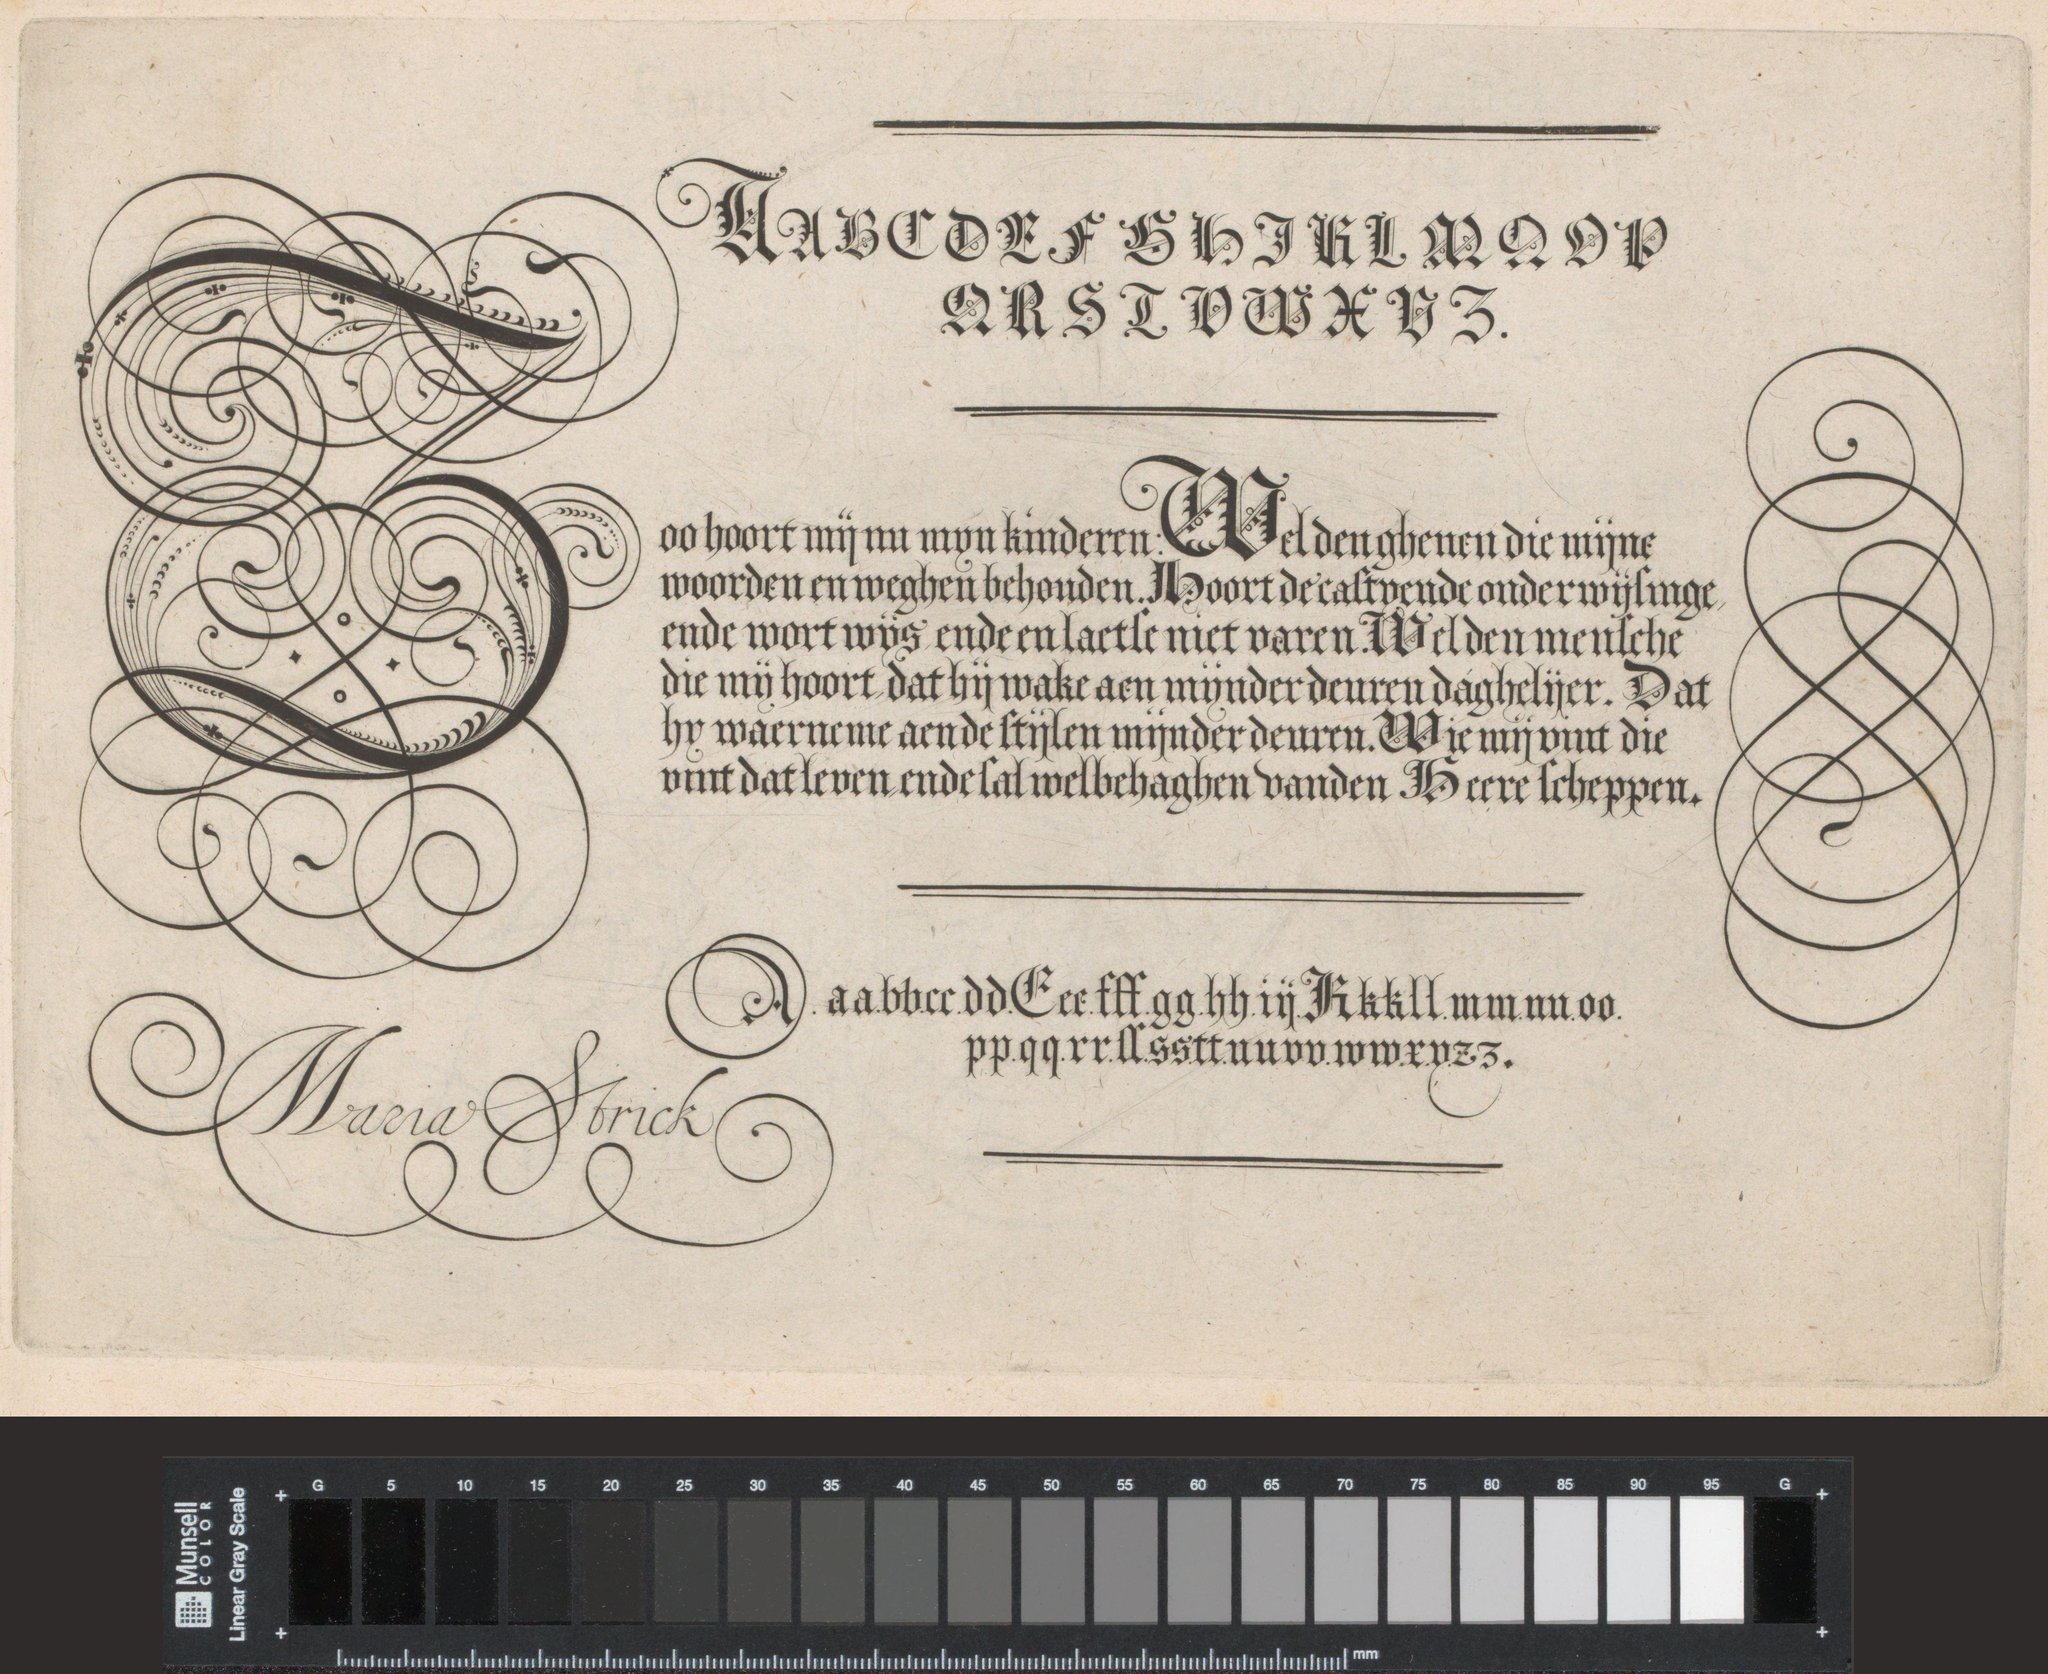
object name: ornament print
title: Schrijfvoorbeeld met kapitaal Z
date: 1618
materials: paper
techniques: engraving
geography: rotterdam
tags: calligraphy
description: Schrijfvoorbeeld met kapitaal Z en zes regels tekst in het Nederlands, tussen twee alfabetten: Zoo hoort mij nu myn kinderen (...). Rechts kalligrafisch krulwerk. De prent maakt deel uit van een album.